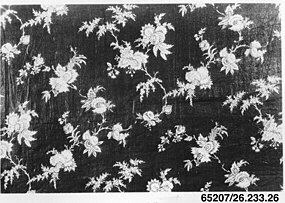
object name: fragment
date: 1775-1780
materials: cotton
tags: flowers